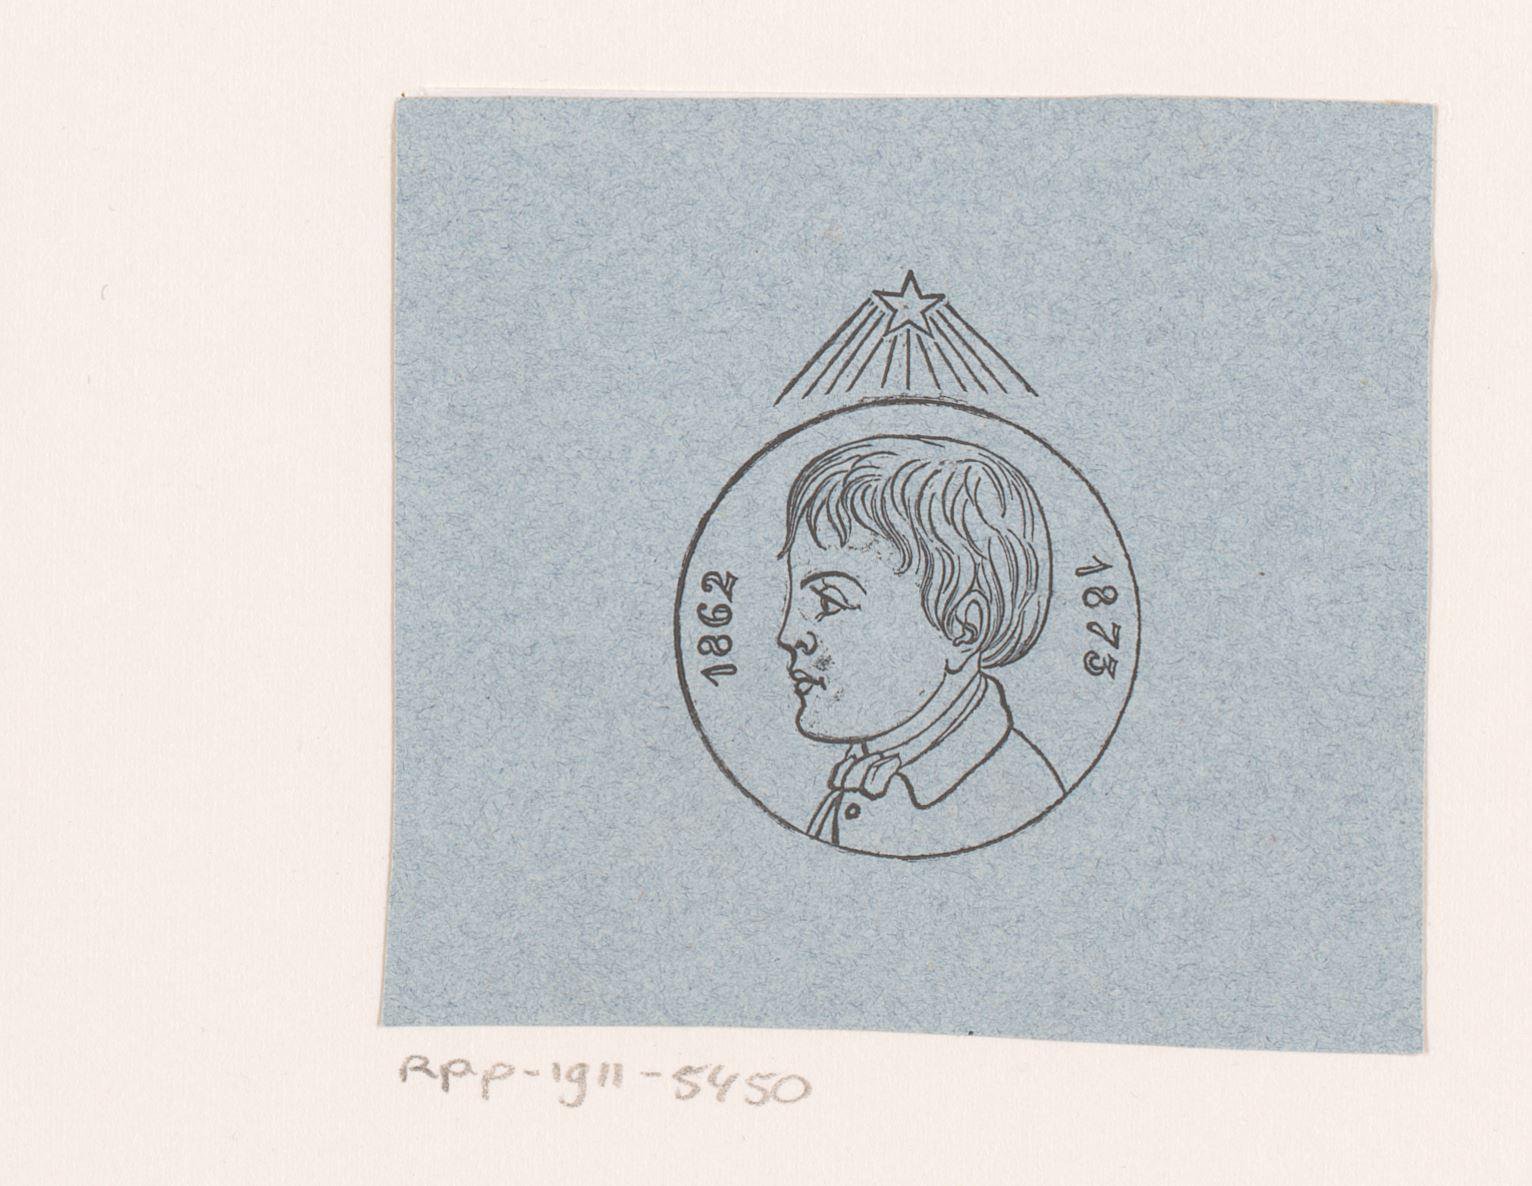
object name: print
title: Portret van Frédéric van de Kerkhove met ster erboven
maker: jan van de kerkhove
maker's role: print maker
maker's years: 1822-1881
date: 1832-1881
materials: paper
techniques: etching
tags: painter, frédéric van de kerkhove, child, historical persons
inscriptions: collector's mark: Lugt 2228